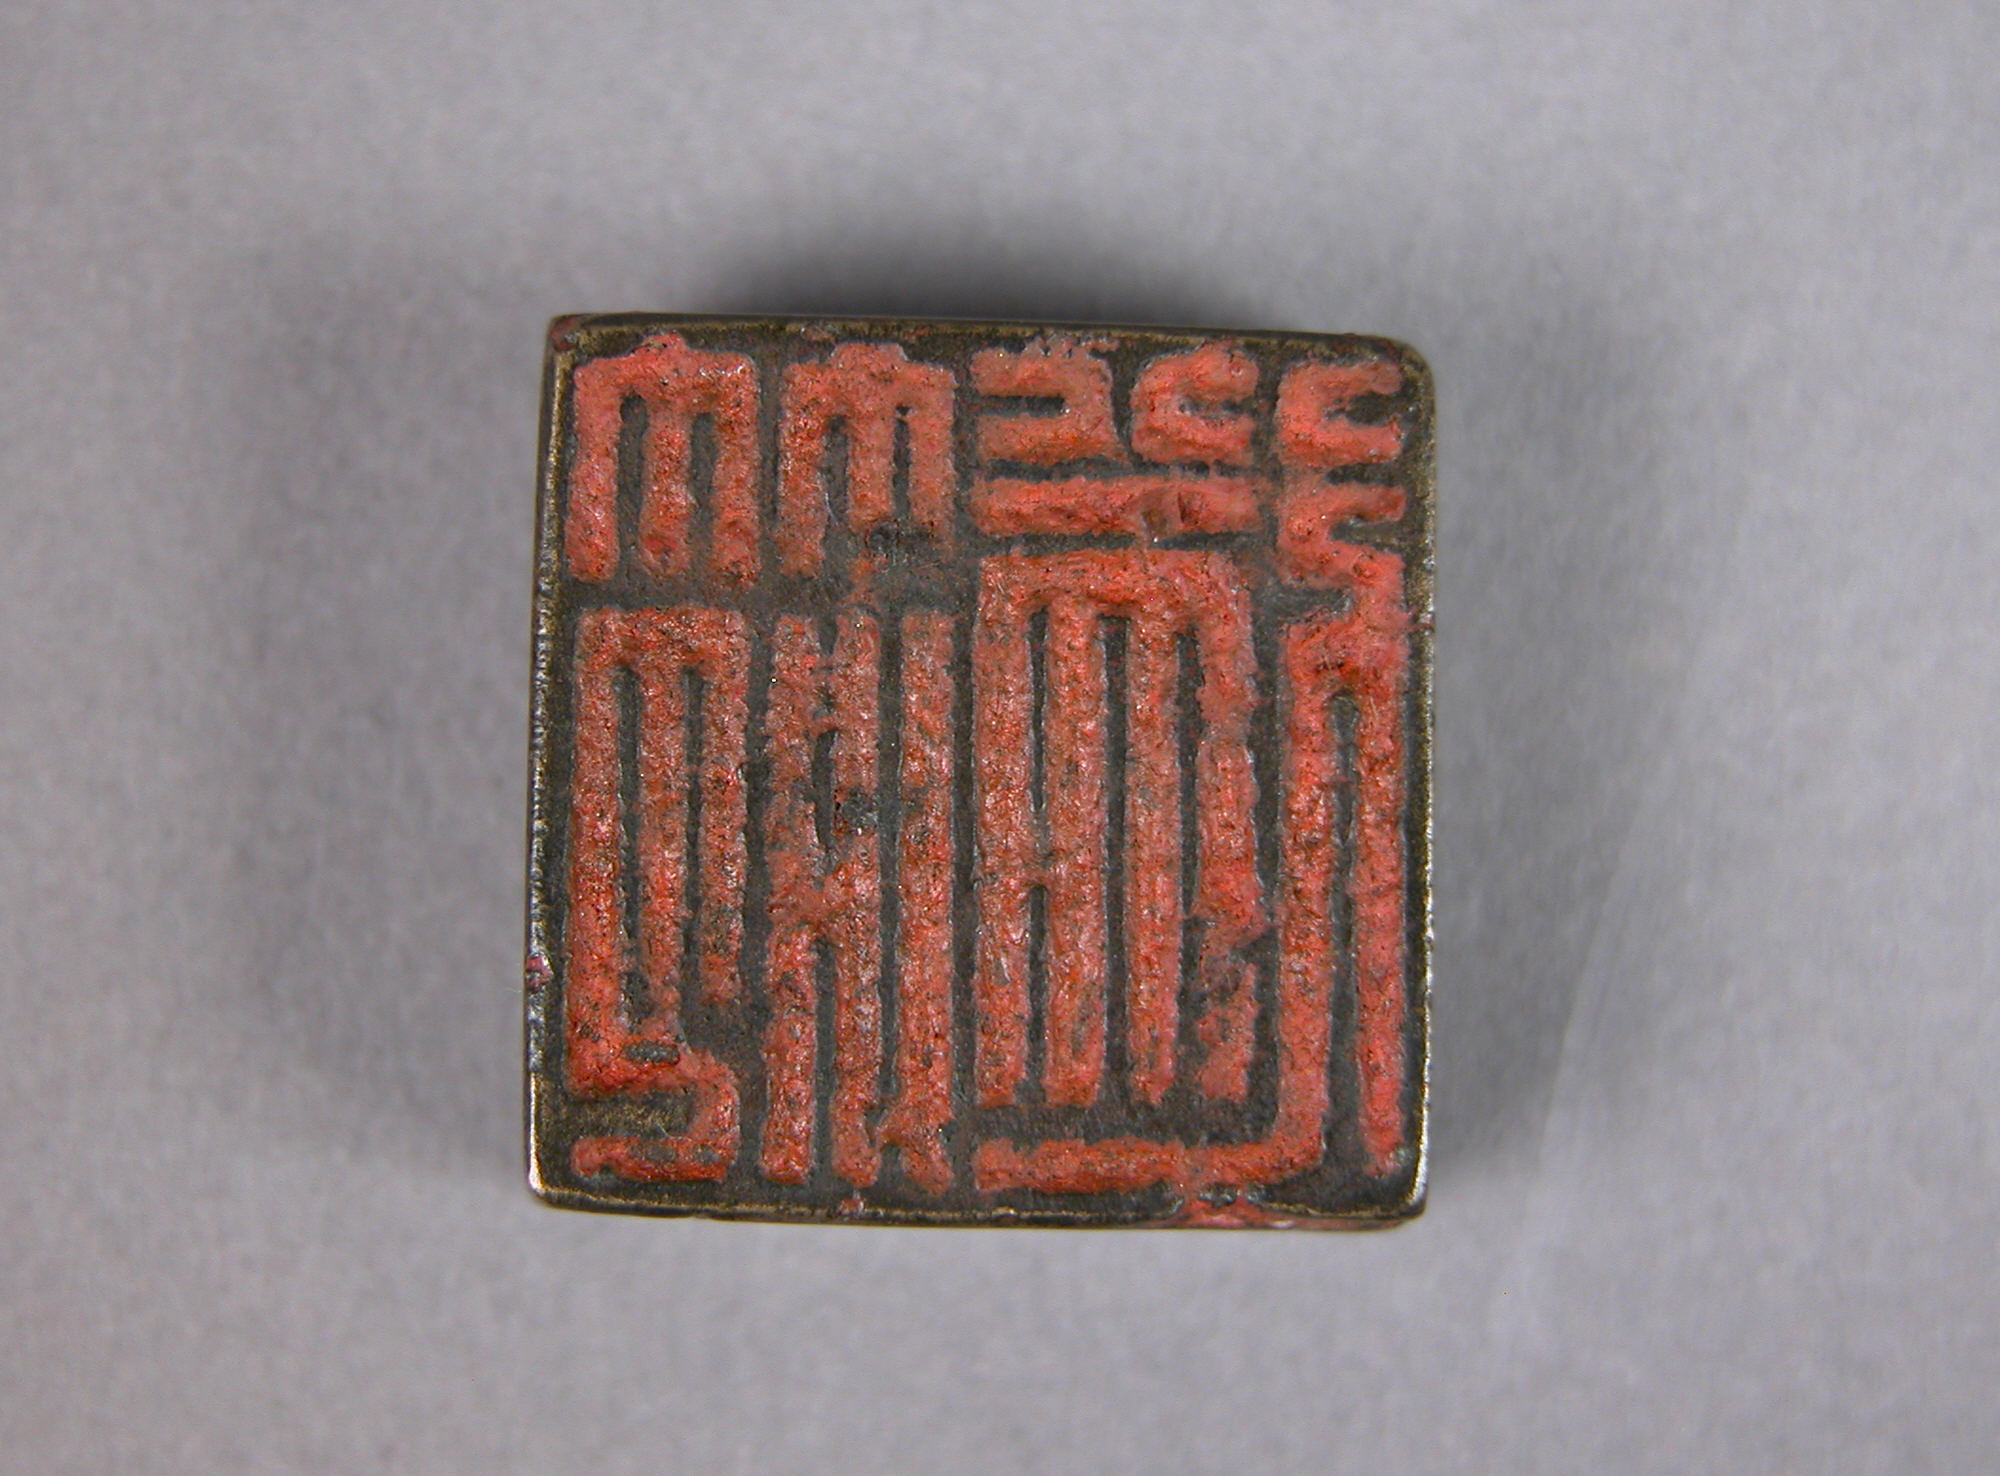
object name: seal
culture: chinese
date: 1368-1644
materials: bronze